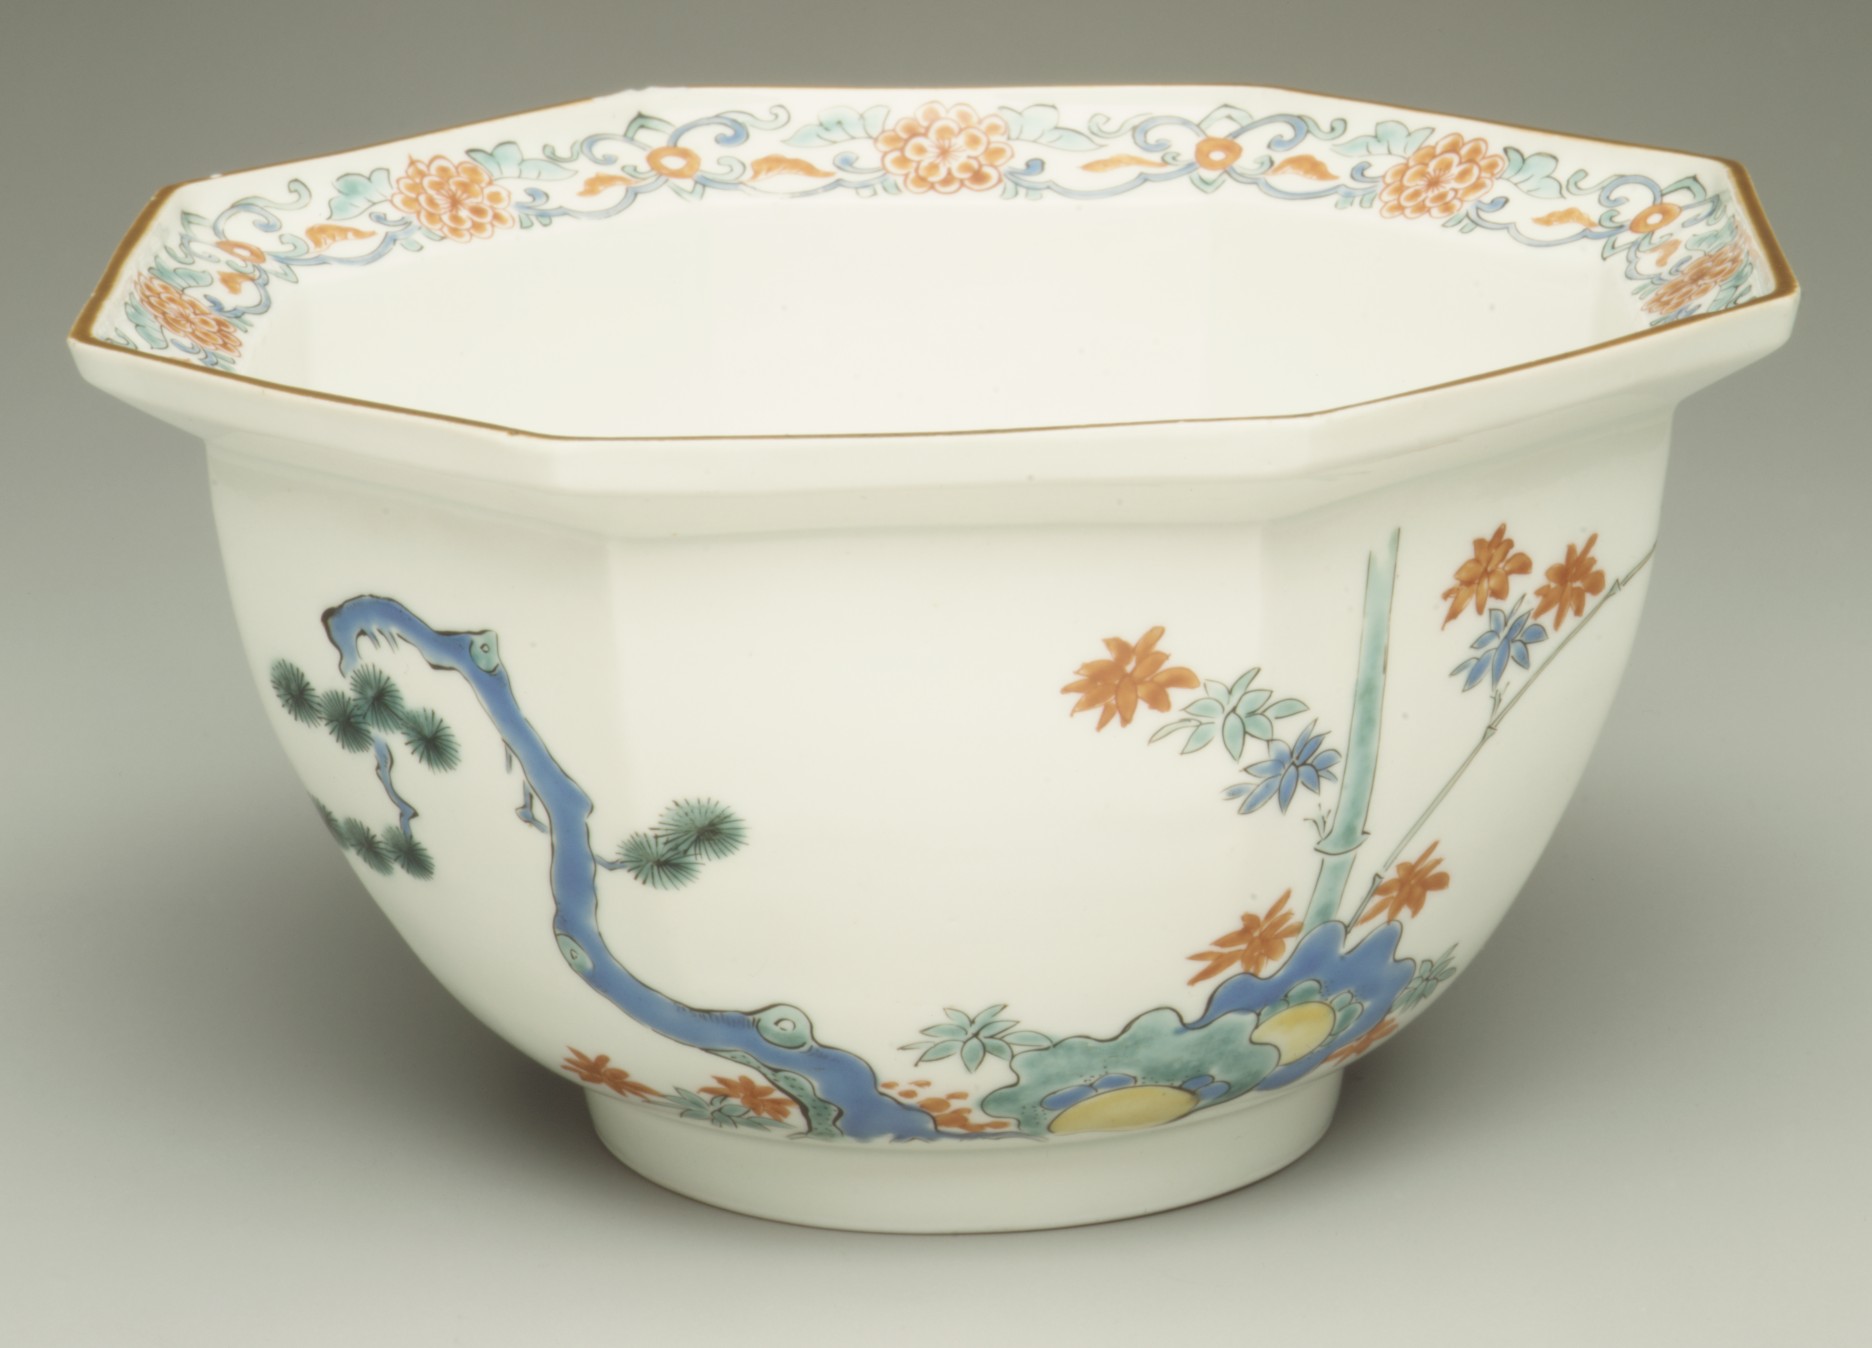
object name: bowl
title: Bowl with rocks and trees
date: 1700-1710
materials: enamel, glaze, hard paste porcelain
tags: flowers,trees